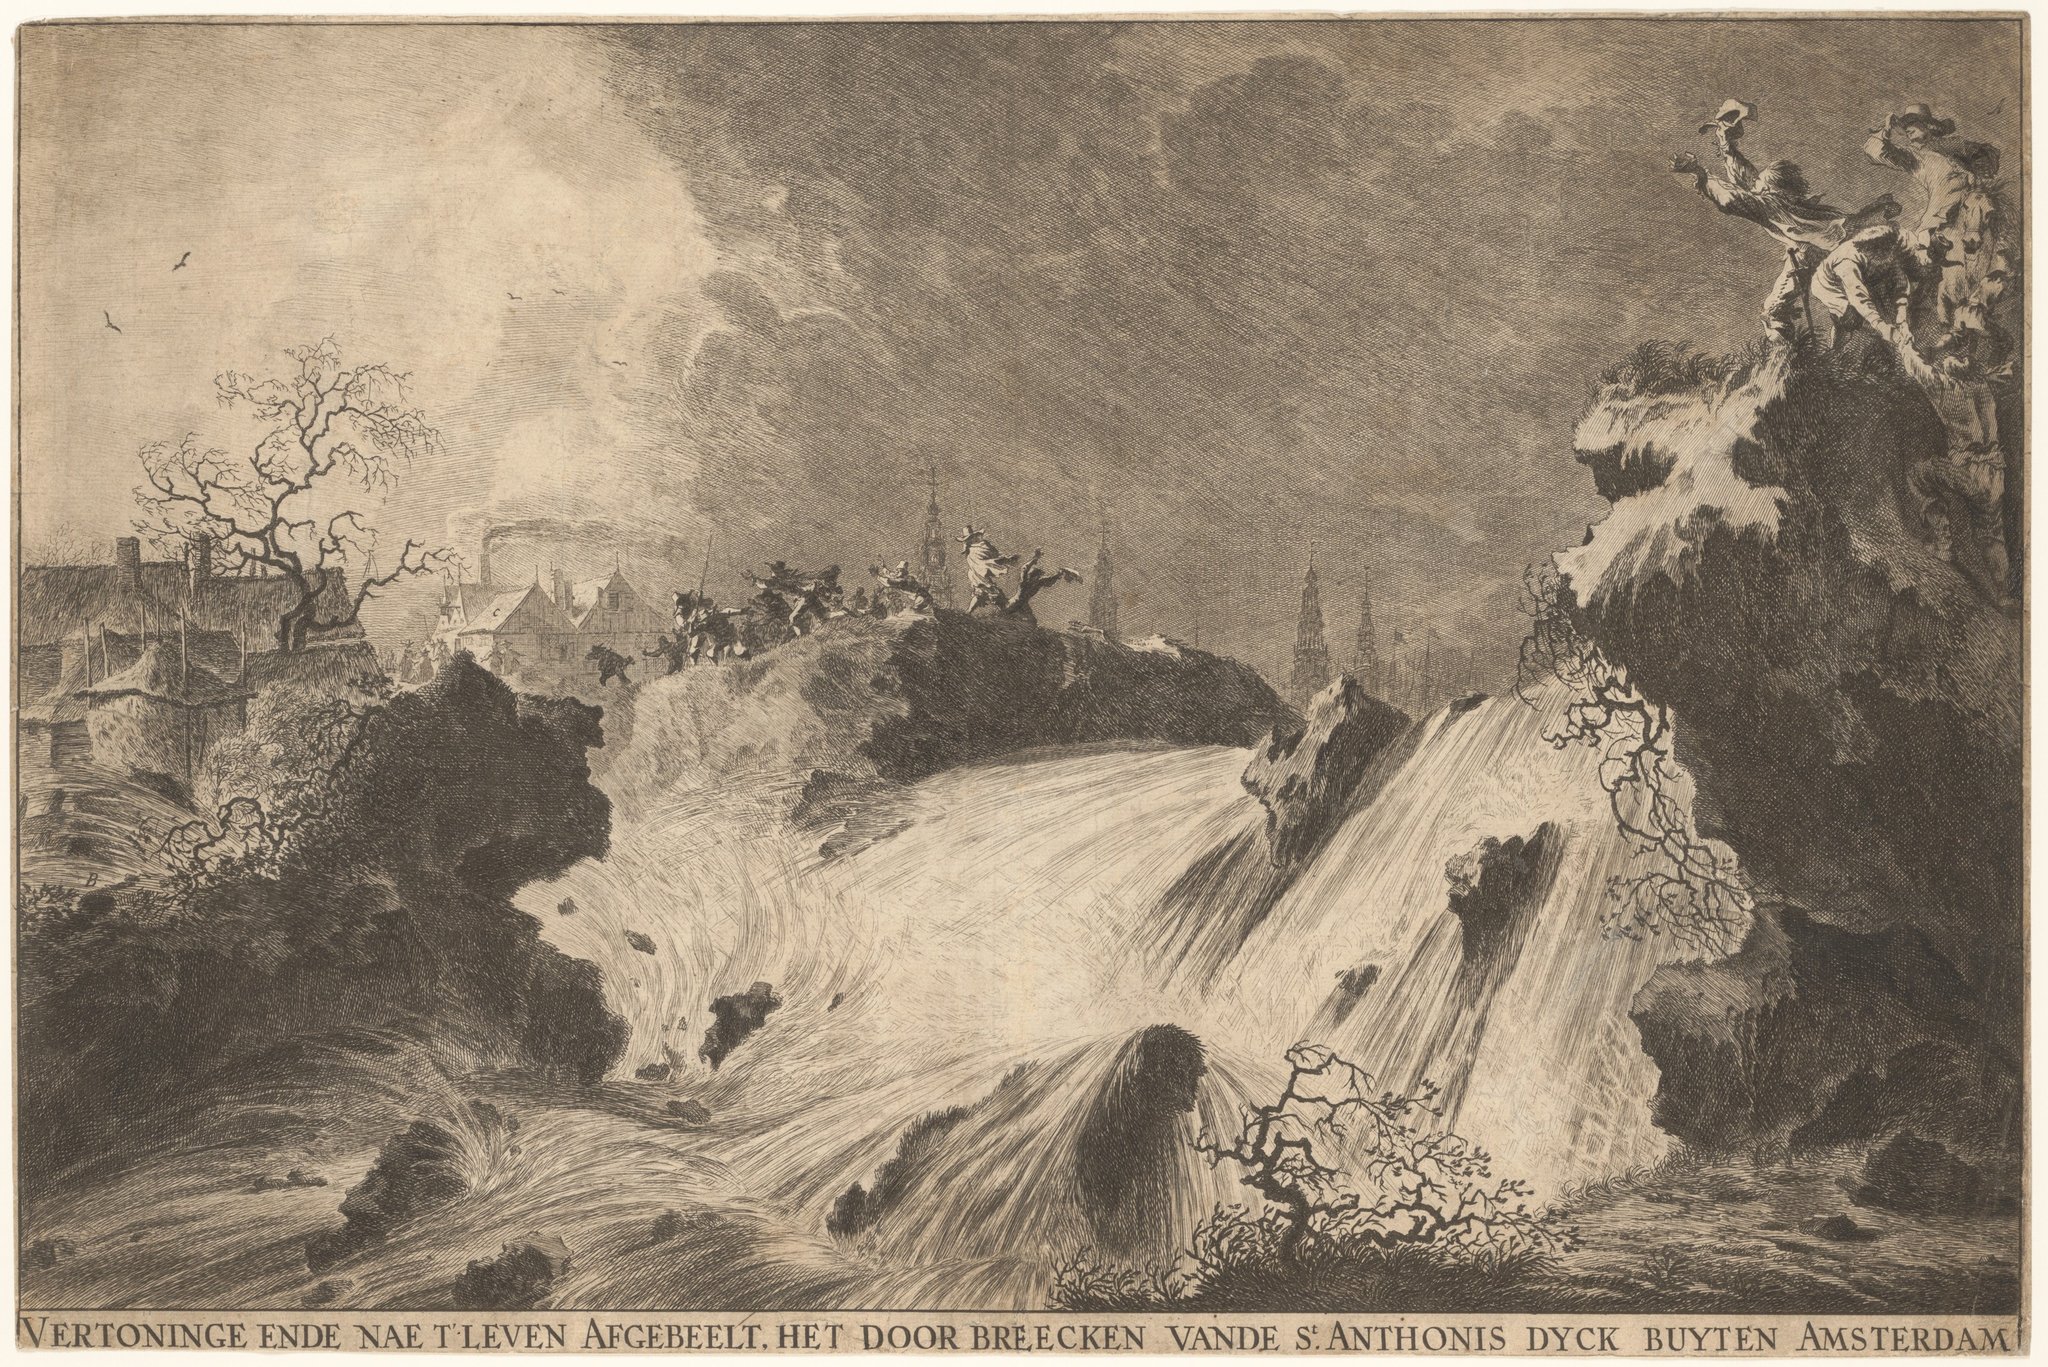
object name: print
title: The Bursting of St. Anthony's Dike, 5 March 1651. Vertoninge...Amsterdam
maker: pieter nolpe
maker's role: artist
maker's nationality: dutch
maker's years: 1613-1614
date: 1601-1700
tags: human figures,waterfalls